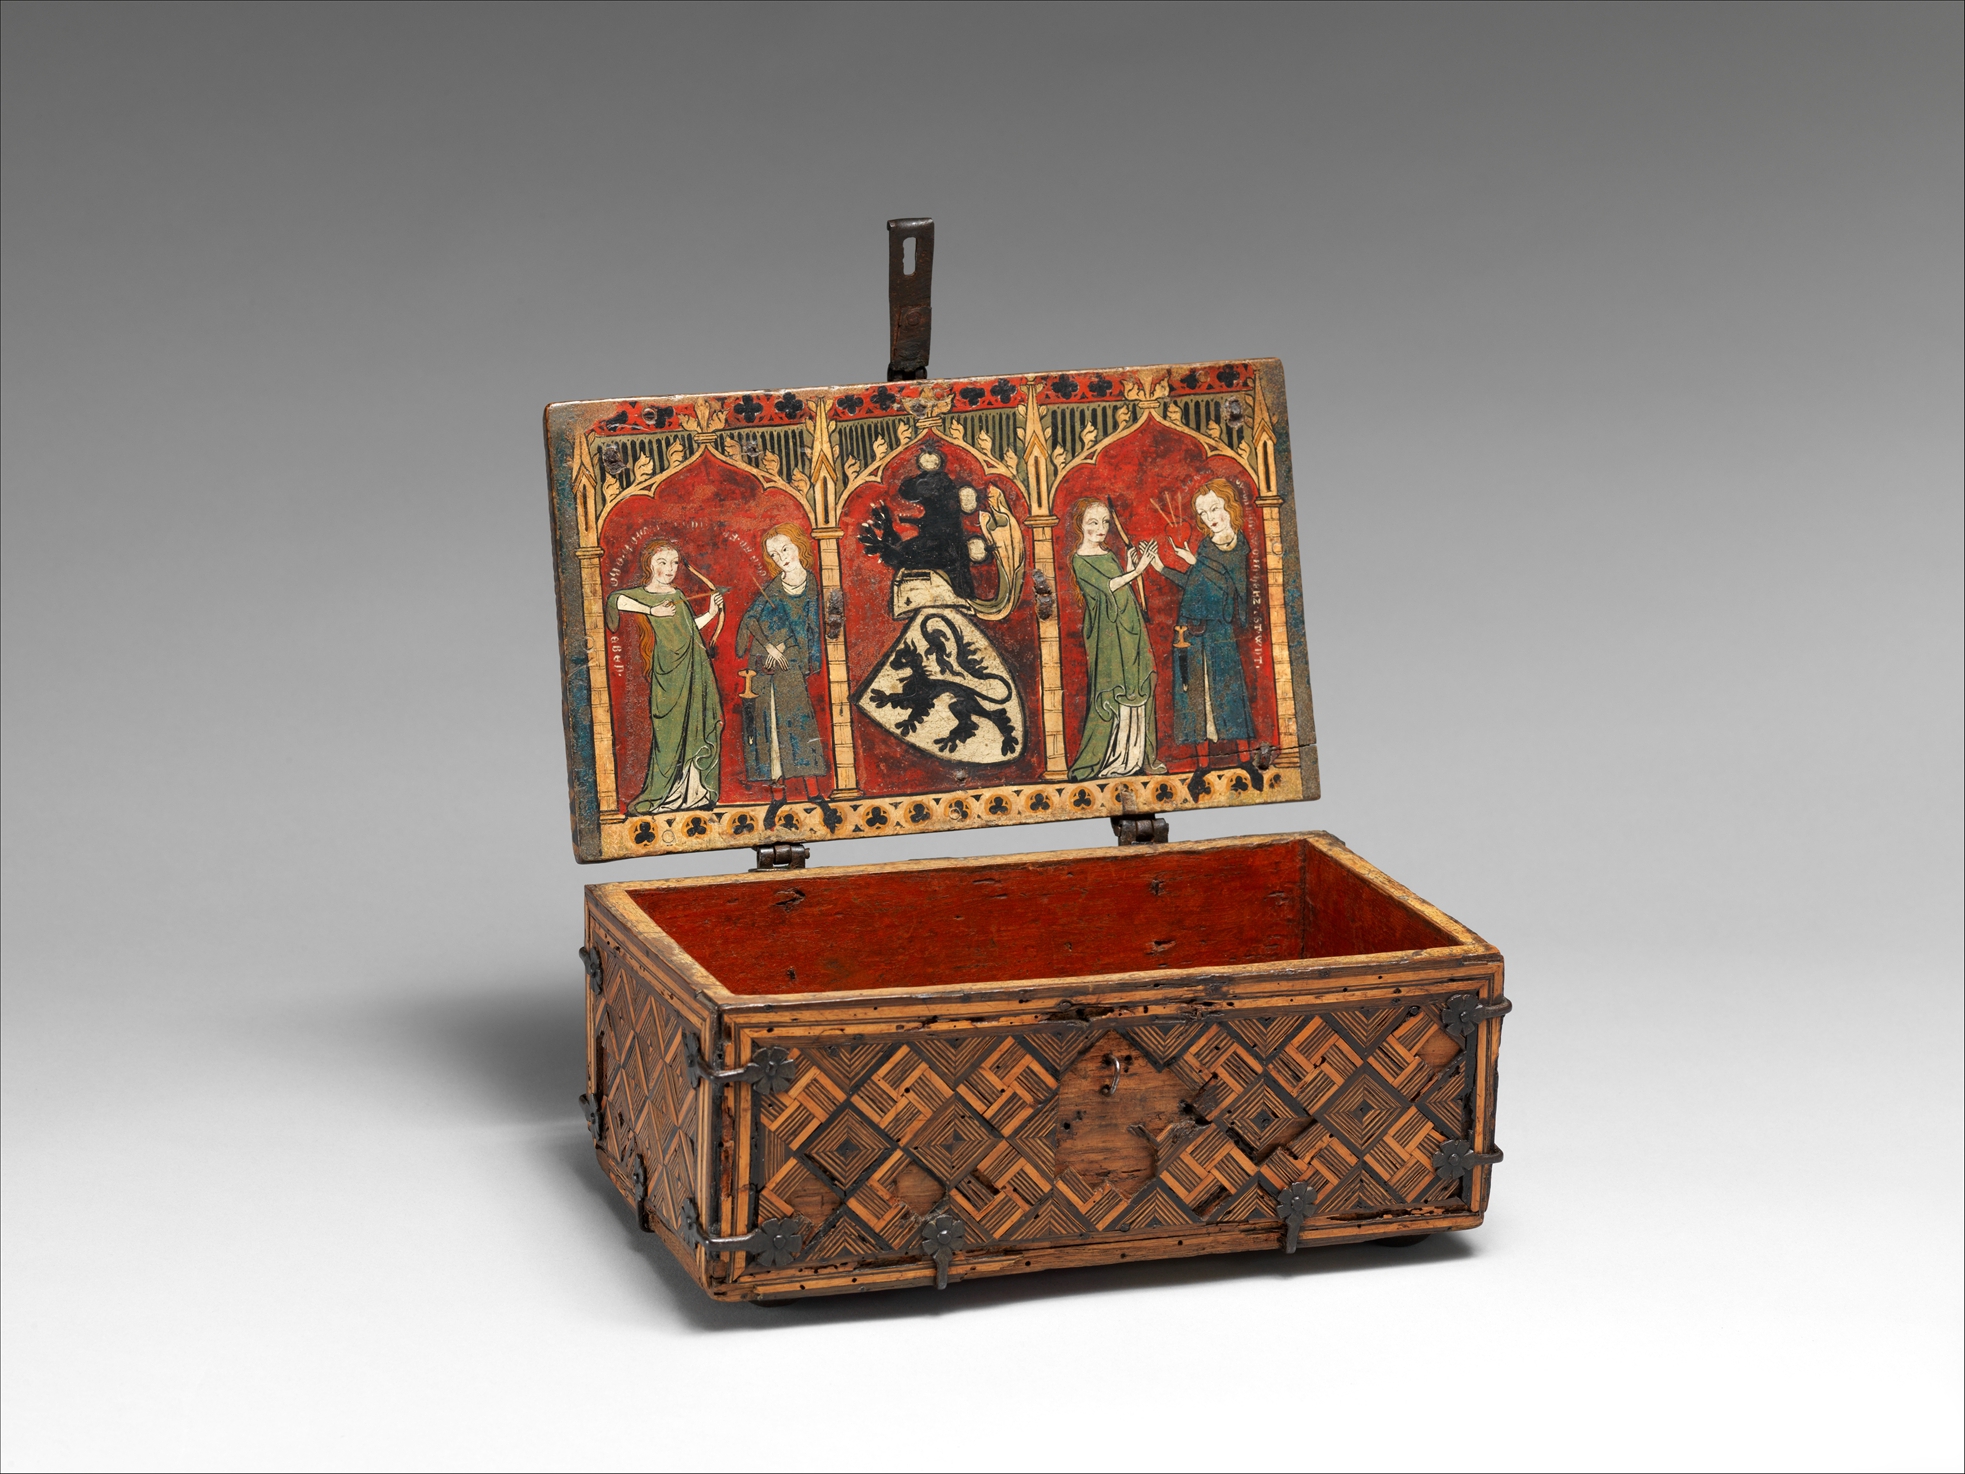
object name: coffret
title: Coffret (Minnekästchen)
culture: german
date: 1325-1350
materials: wood, paint, iron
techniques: inlay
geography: germany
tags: men,women,coat of arms